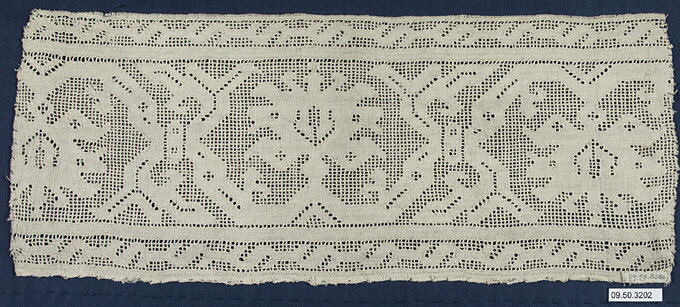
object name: border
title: Border fragment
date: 1501-1700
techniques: embroidery